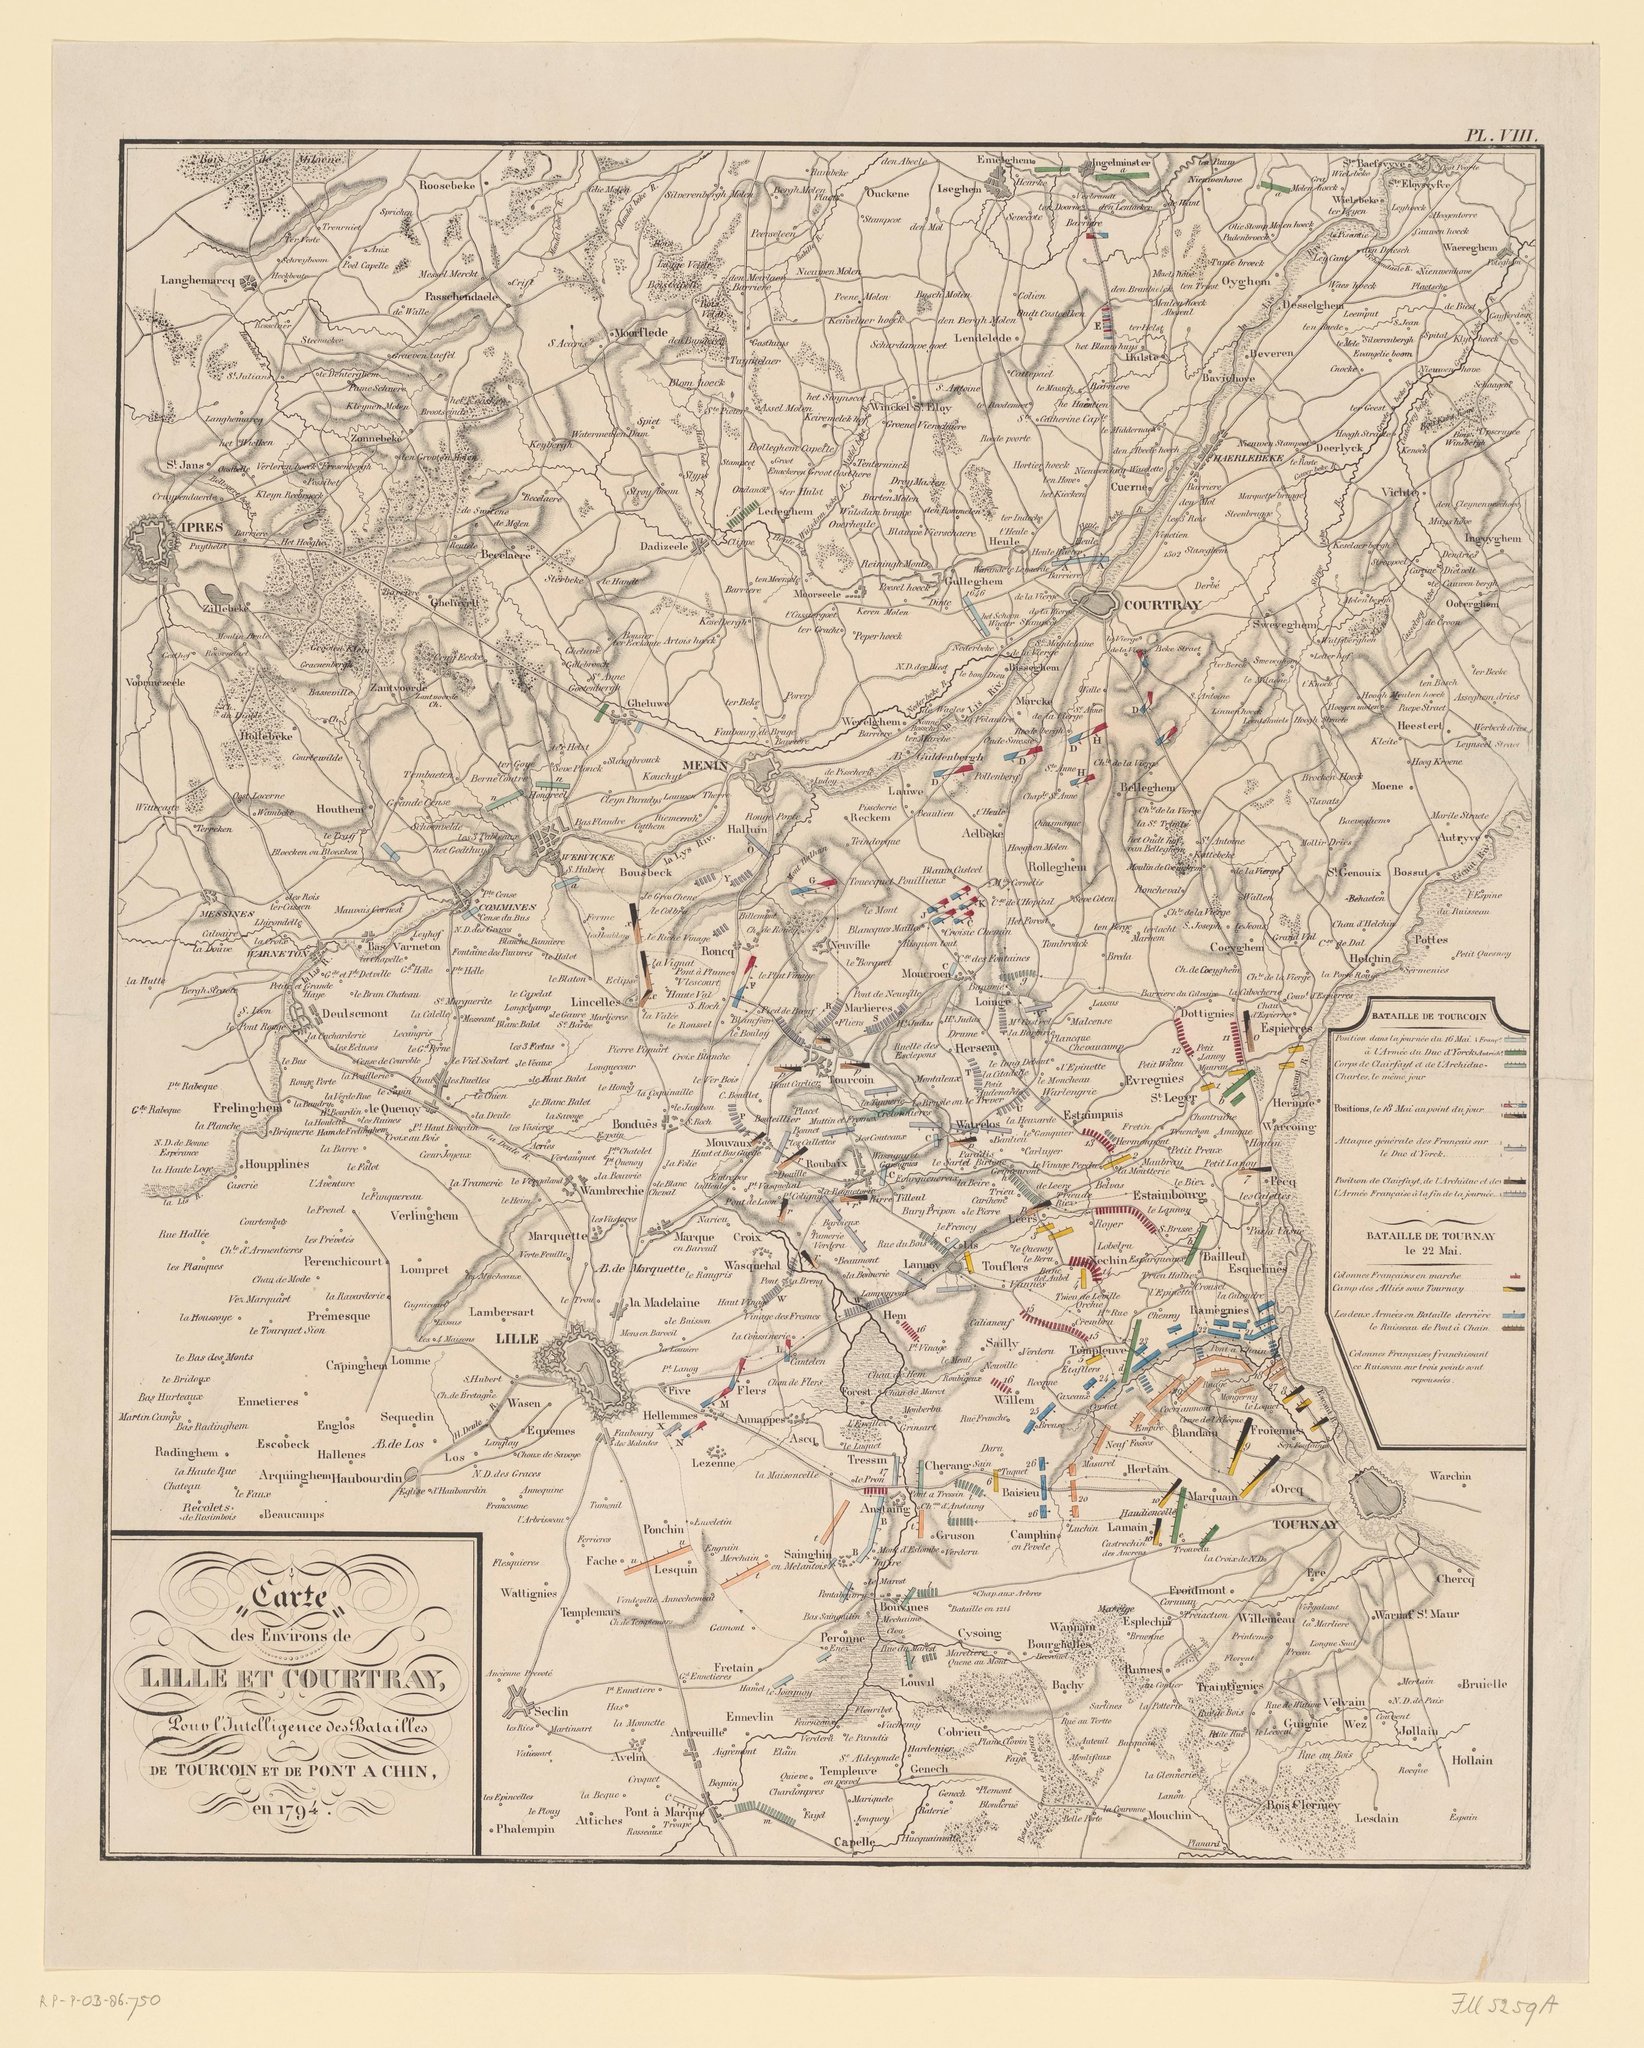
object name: history print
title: Carte des Environs de Lille et Courtray, Pour l'Intelligence des Batailles de Tourcoin et de Pont a Chin, en 1794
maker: Anonymous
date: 1800-1850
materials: paper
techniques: hand coloring, lithograph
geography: france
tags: maps of separate countries or regions, lille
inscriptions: collector's mark: Lugt 2228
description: Kaart van het gebied tussen Lille, Tournai en Courtrai, waar op 16 en 22 mei 1794 veldslagen plaatsvonden tussen het Franse Revolutionaire leger en de Geallieerden. Op de kaart zijn de posities van de troepen in kleuren aangegeven. Genummerd rechtsboven: Pl. VIII.